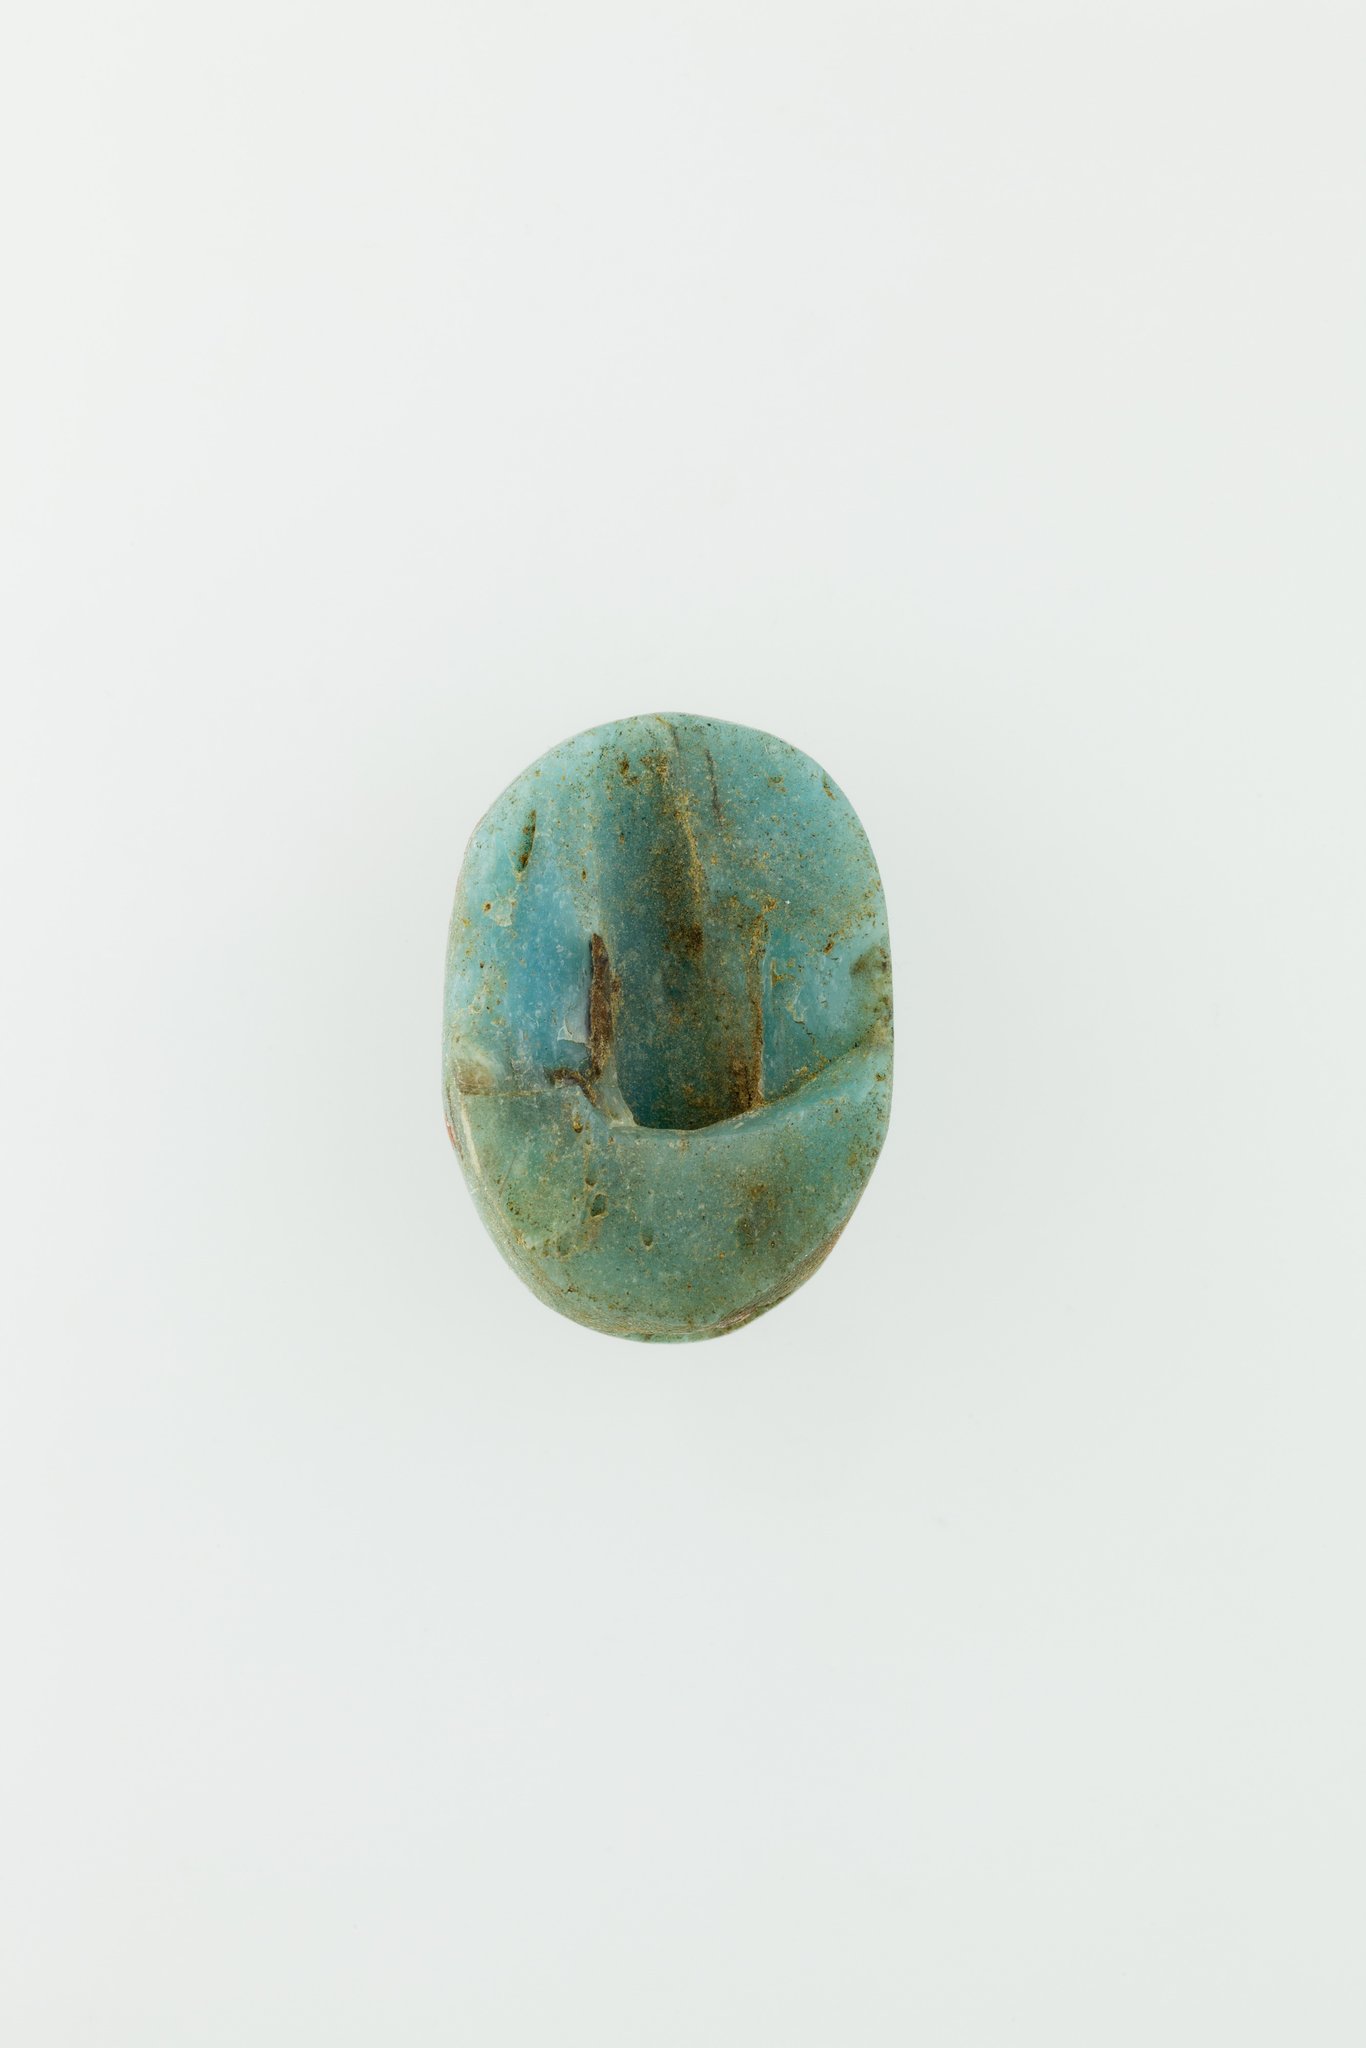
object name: scarab, uninscribed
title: Uninscribed glass scarab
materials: glass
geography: egypt